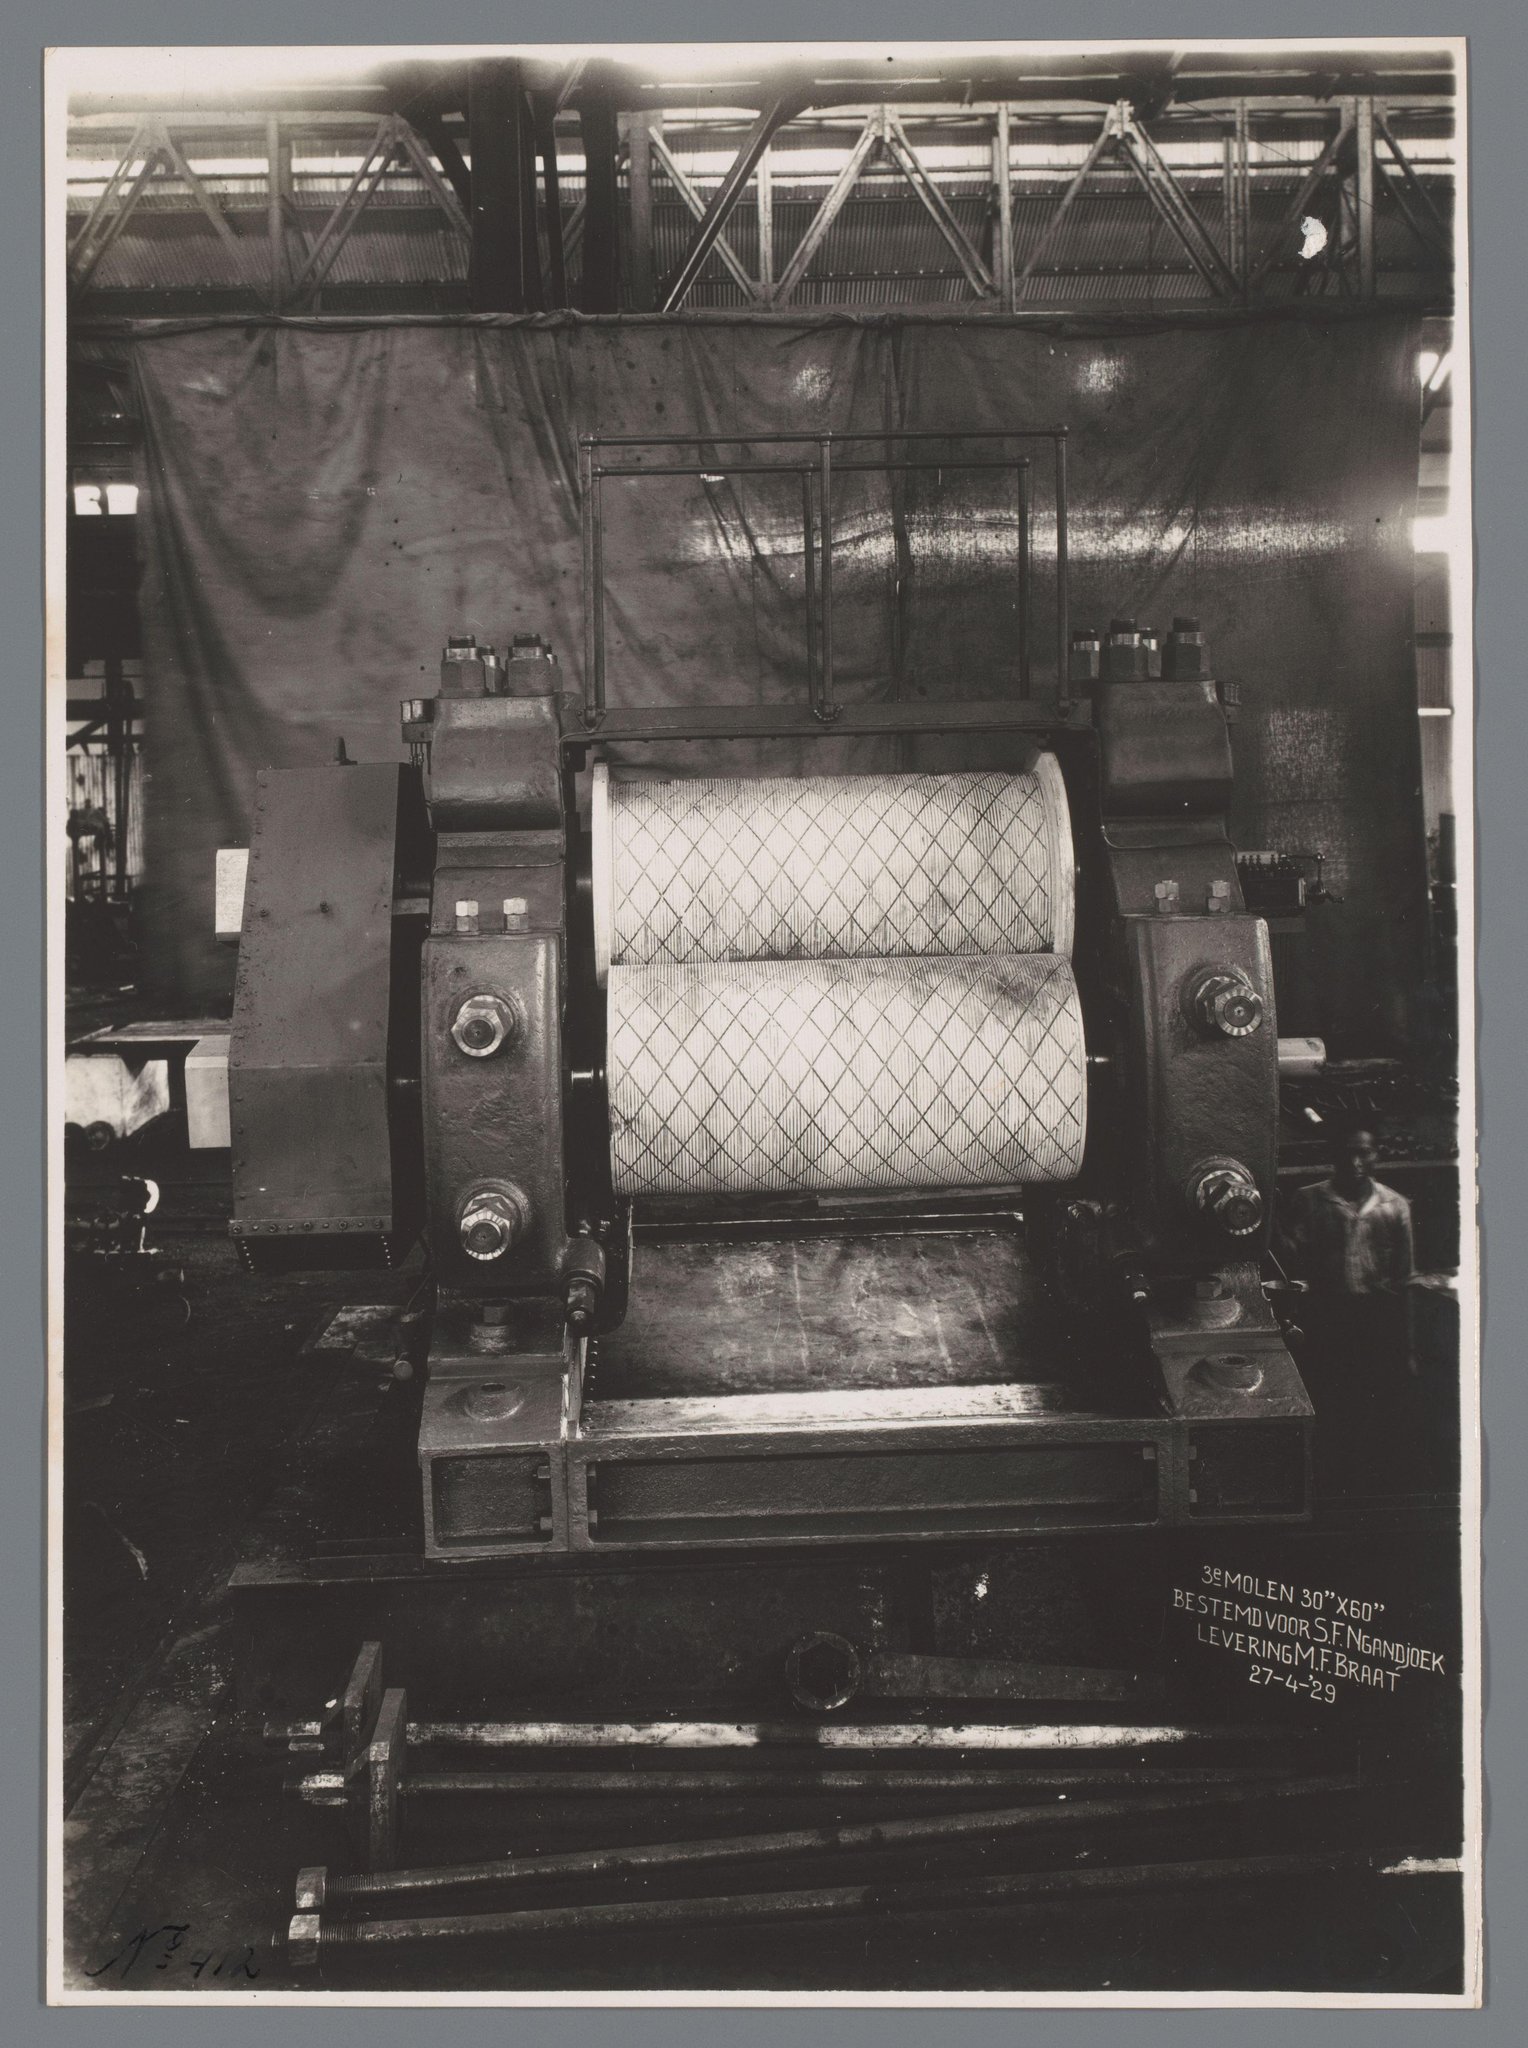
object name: photograph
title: Molen voor suikerfabriek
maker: Anonymous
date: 1929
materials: photographic support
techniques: gelatin silver print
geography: surabaya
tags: colonial system, factory-interior, machine shop, machines; parts of machines; tools and appliances, (non-fruit) products of plants or trees: sugarcane, java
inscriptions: date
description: Een molen voor een machine vervaardigd 1929 en bestemd voor de suikerfabriek Ngandjoek. Onderdeel van de multomap met foto's van machines van de N.V. Machinefabriek Braat te Soerabaja bestemd voor de Nederlandse suikerindustrie op Java, uit de periode 1917-1938.